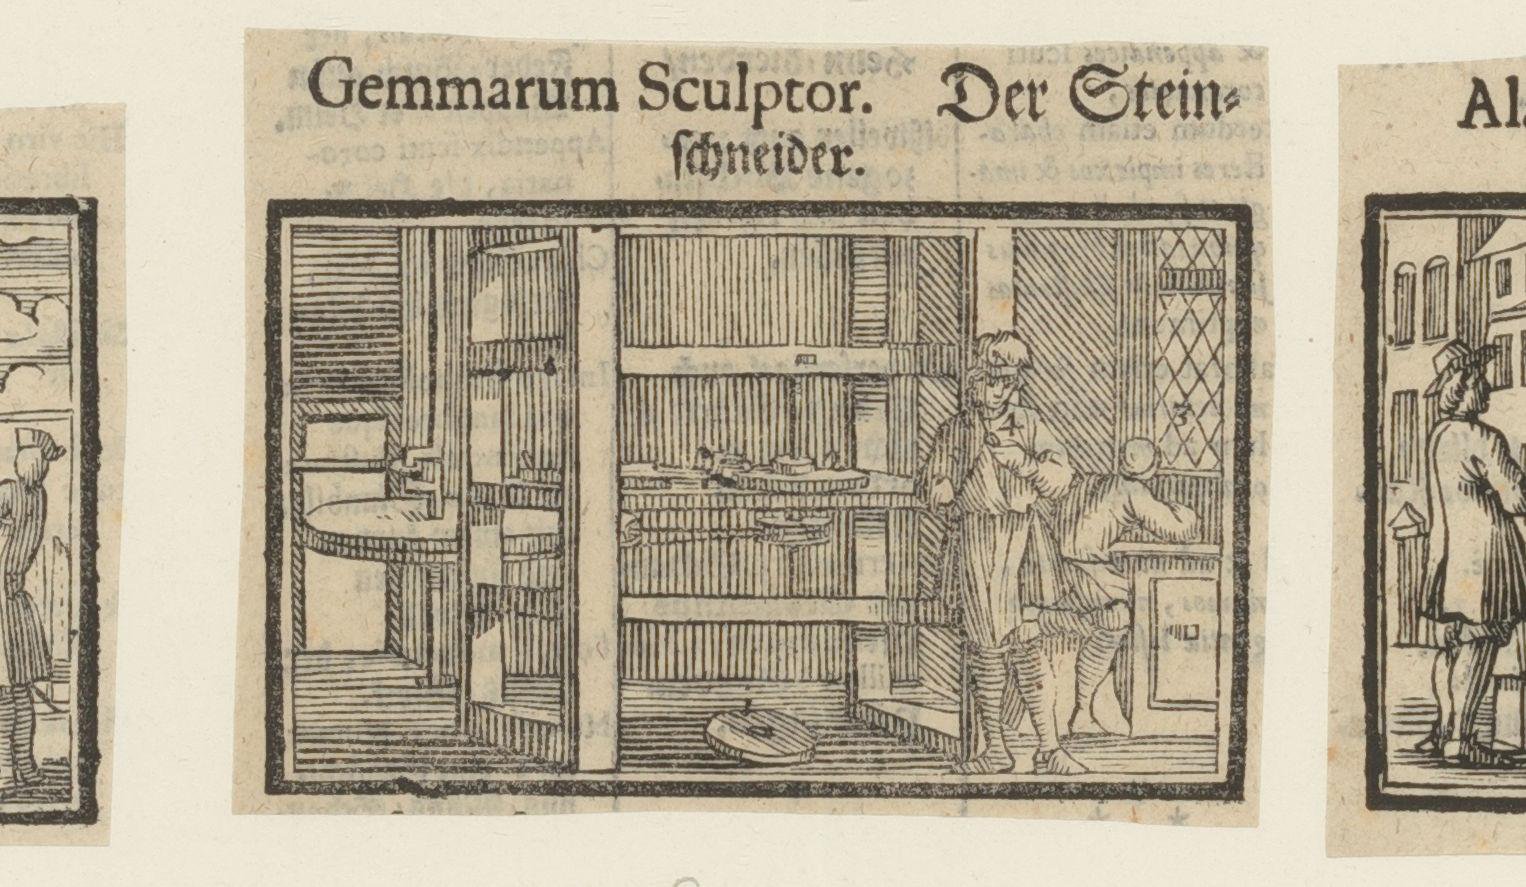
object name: print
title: Gemmarum Sculptor. Der Stein-schneider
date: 1719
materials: paper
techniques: letterpress printing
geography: nuremberg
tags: handicrafts, craftsman at work, sculptor at work, handicrafts ~ stone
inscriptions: stamp, collector's mark: Lugt 1641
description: Prent uit: Comenius, Johannes Amosius. Orbis sensualium picti pars prima (...). Neurenberg: Martin Endter, 1719, dl. 2, p. 106. Prent eerder gebruikt in: Comenius, Johannes Amosius. Orbis Sensualium Picti denuo aucti Pars Secunda (...). Neurenberg: Martin Endter, 1730, dl. 2.